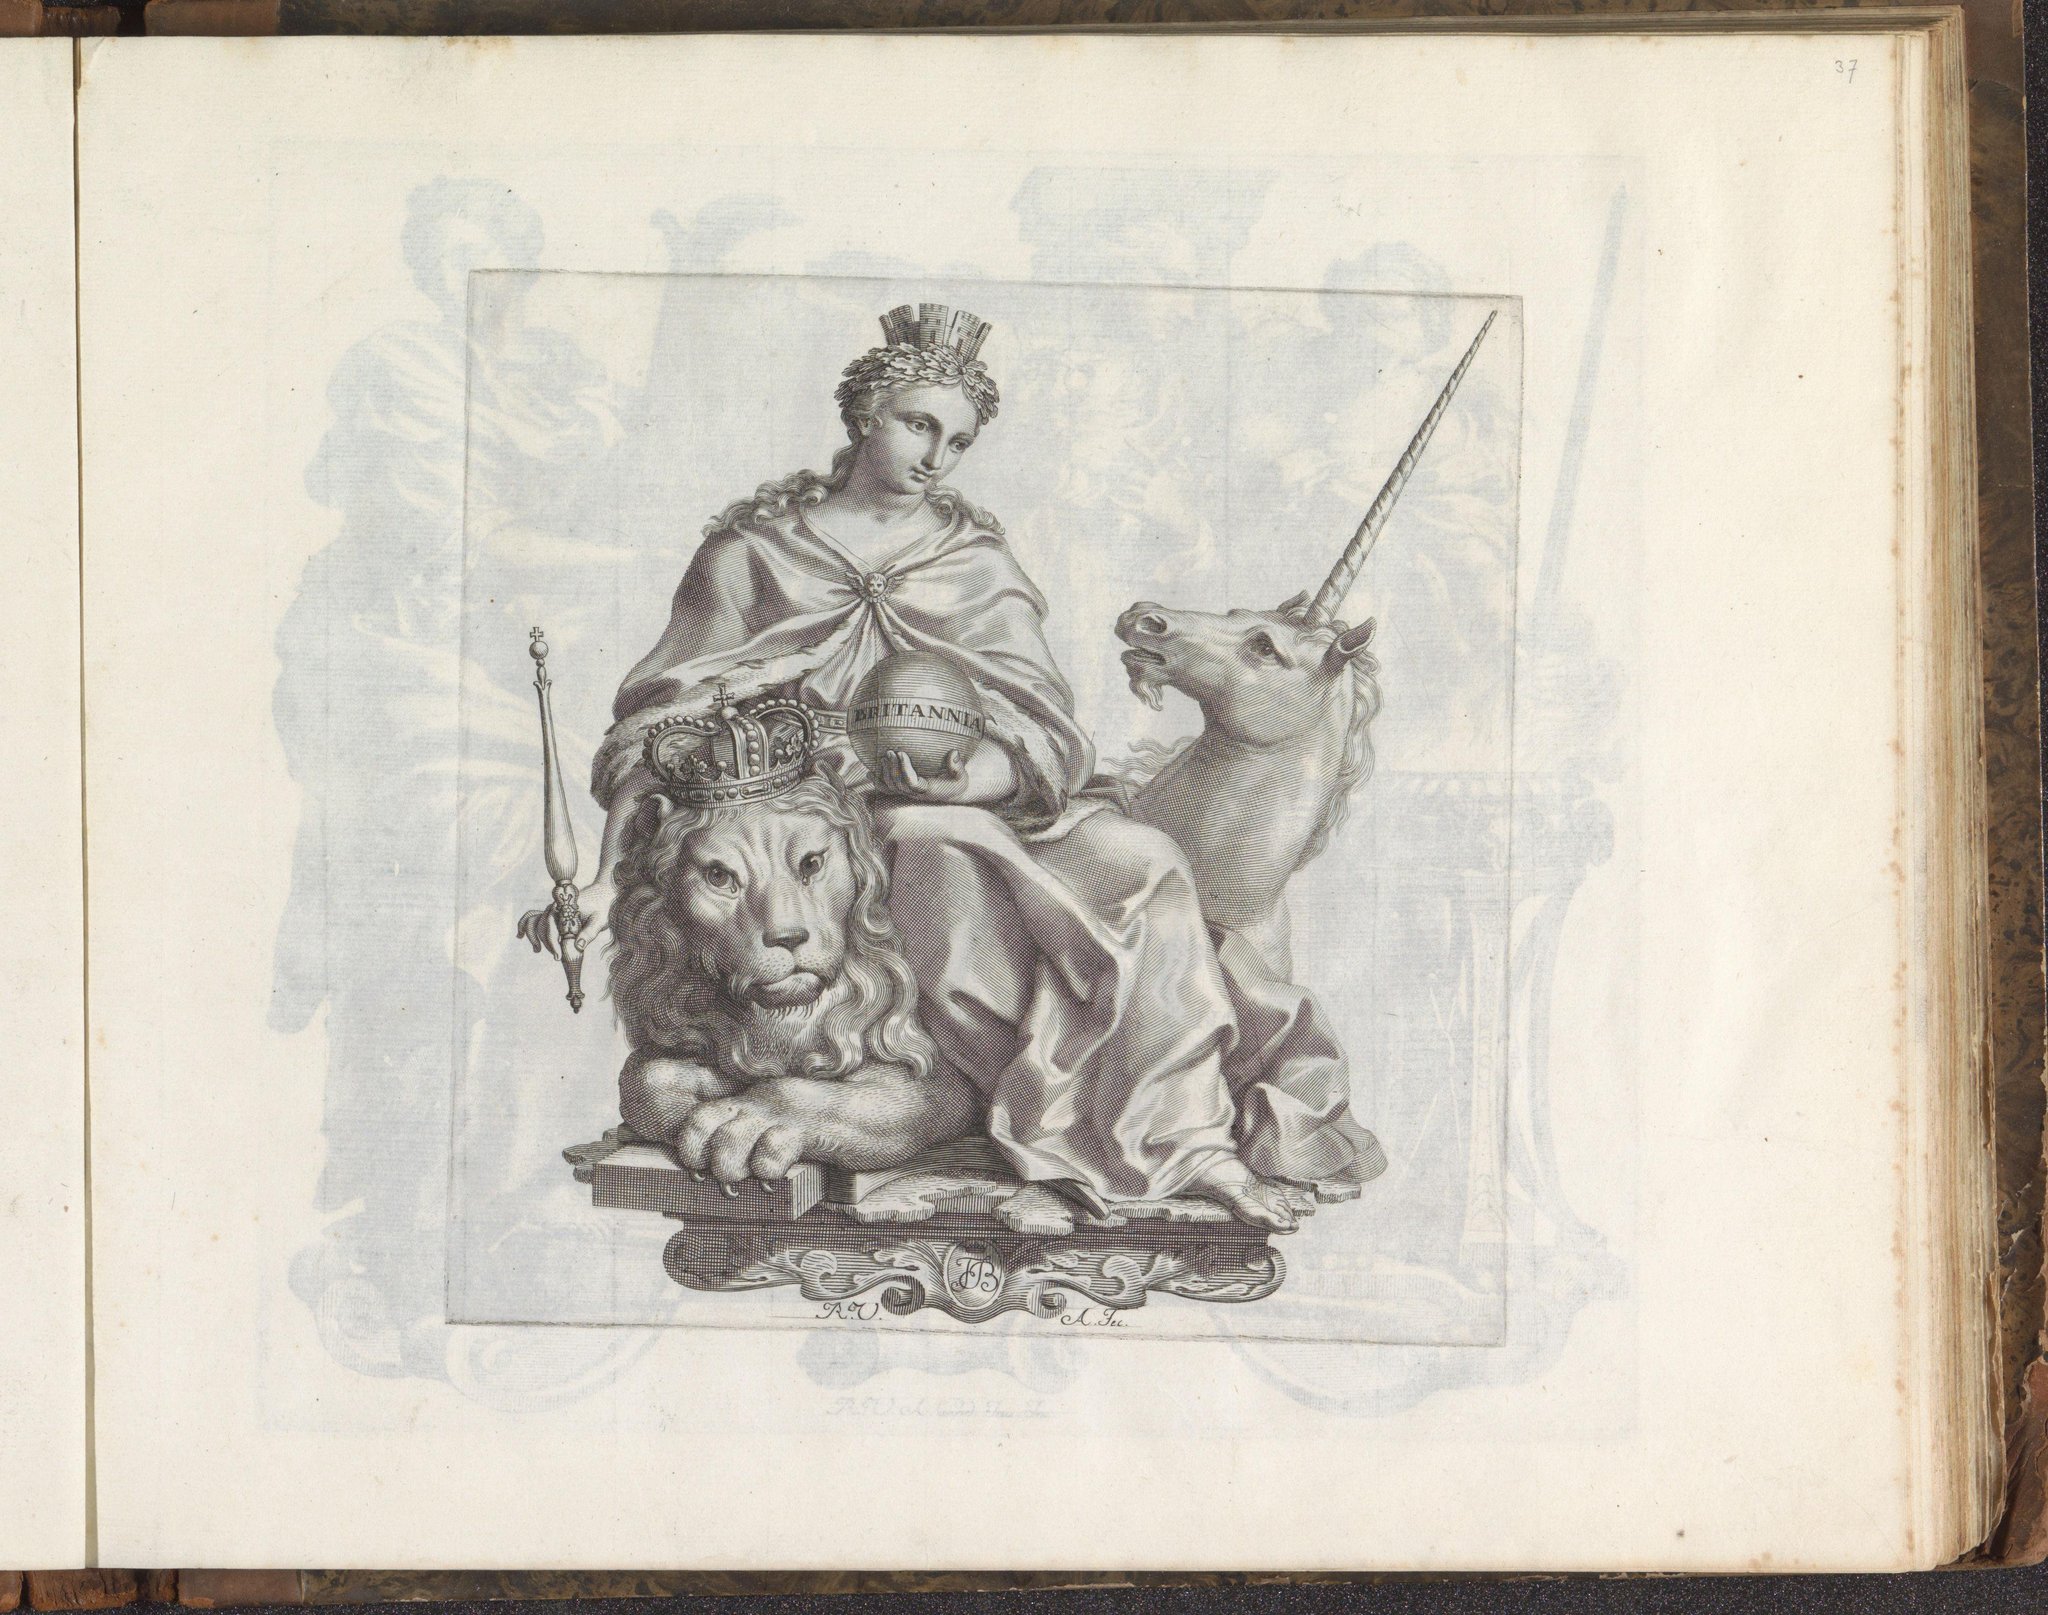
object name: album leaf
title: Numismata virorum illustrium ex Barbadica gente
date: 1673-1743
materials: paper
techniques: engraving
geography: rome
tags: unicorn, personifications of countries, nations, states, districts, etc., beasts of prey, predatory animals: lion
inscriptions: collector's mark: Lugt 2228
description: Een console met de vrouwelijke personificatie van Britannia. Op haar hoofd draagt zij een muurkroon en ze heeft een scepter in haar handen. Ze zit op een gekroonde leeuw en een eenhoorn, de schildhouders van het wapen van het Verenigd Koninkrijk. De prent maakt deel uit van een album.